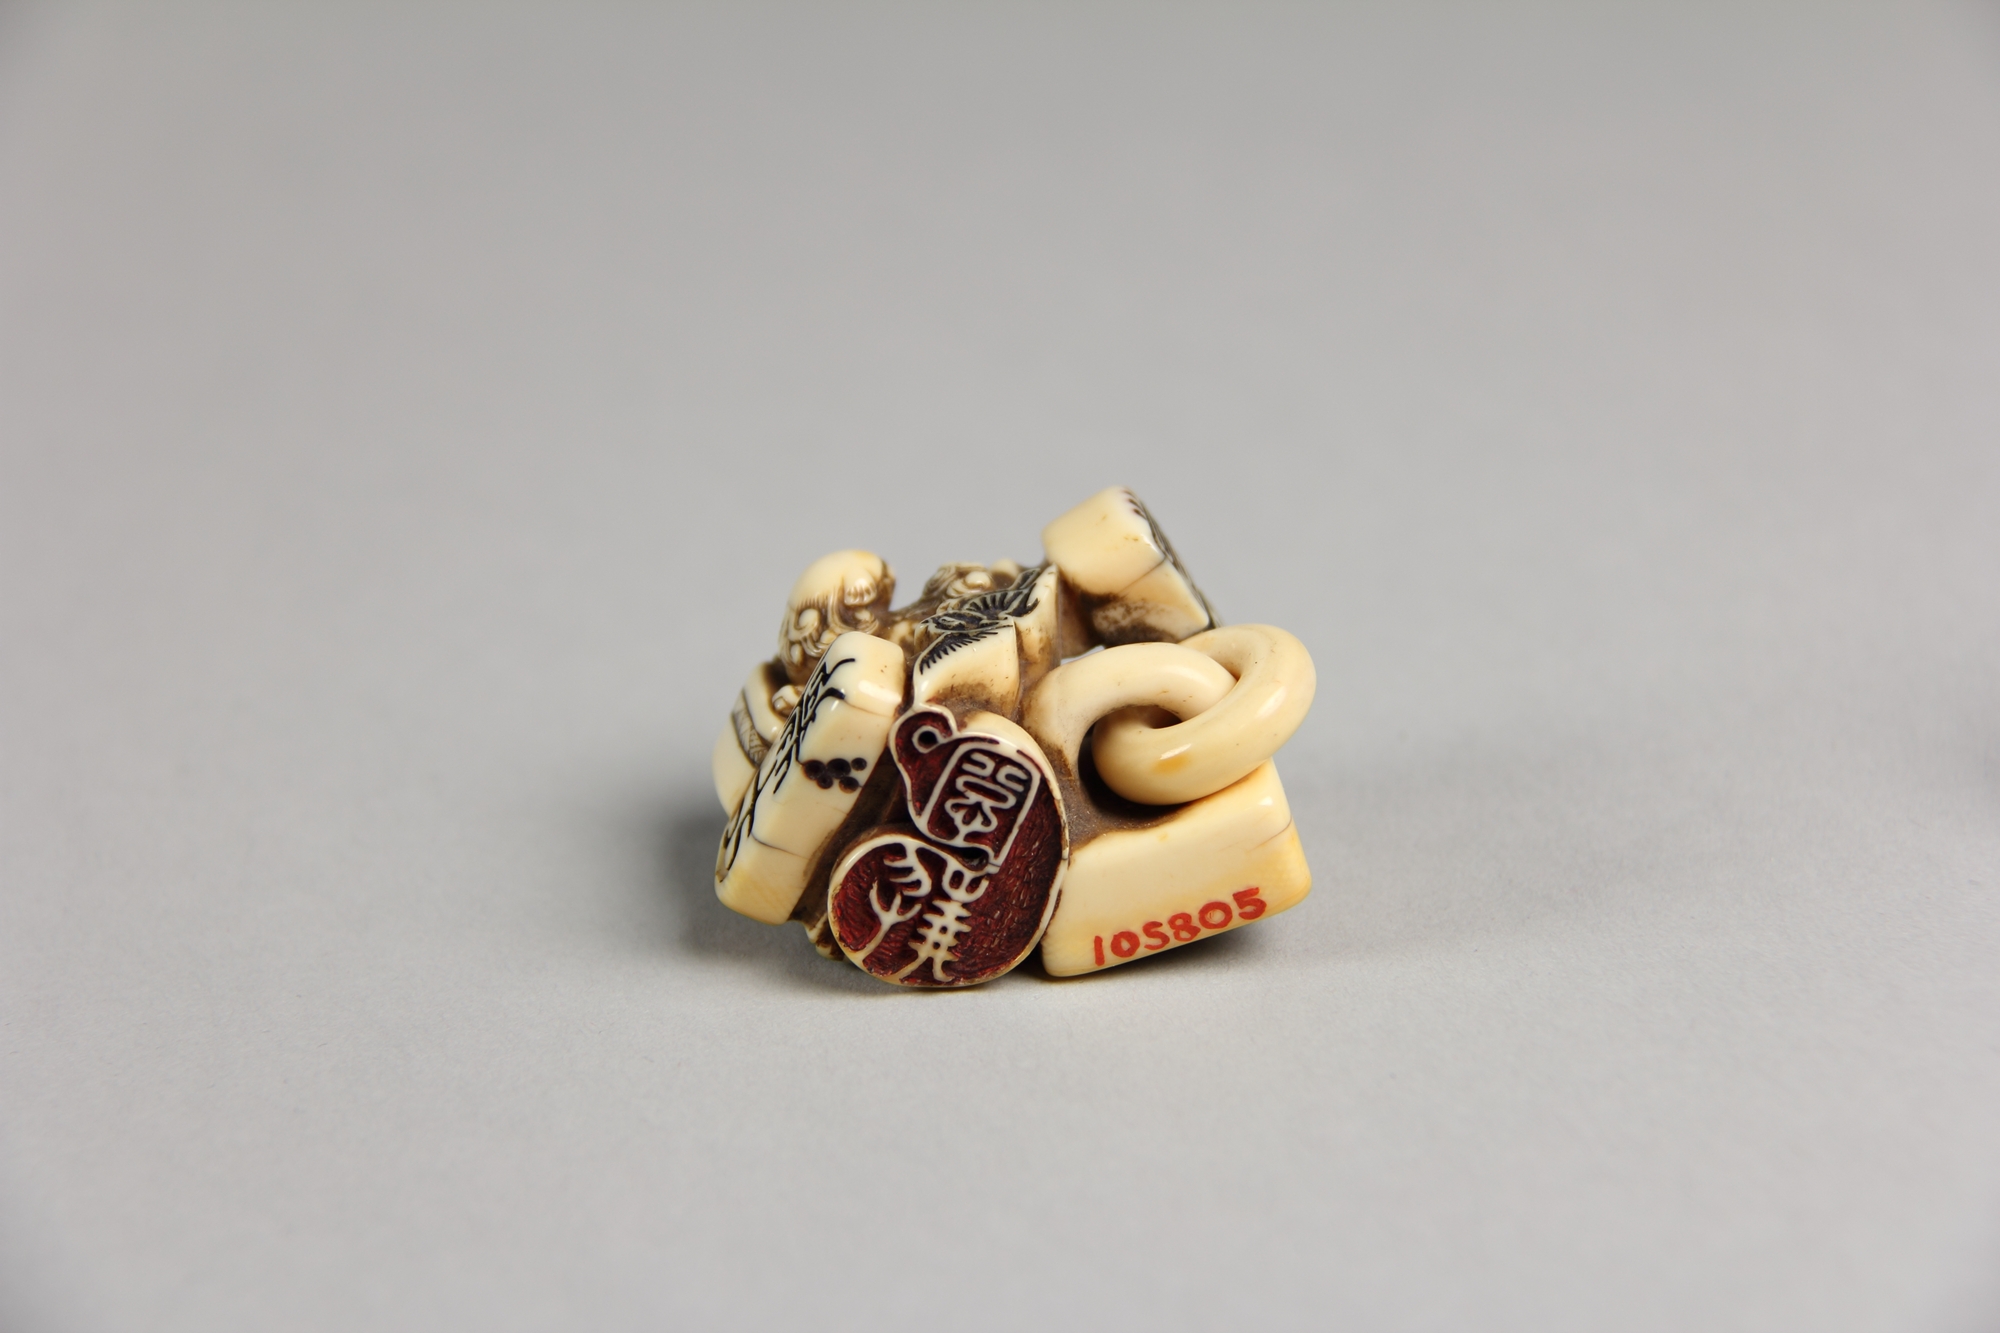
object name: netsuke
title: Netsuke of Group of Seals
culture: japanese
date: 1801-1900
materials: ivory